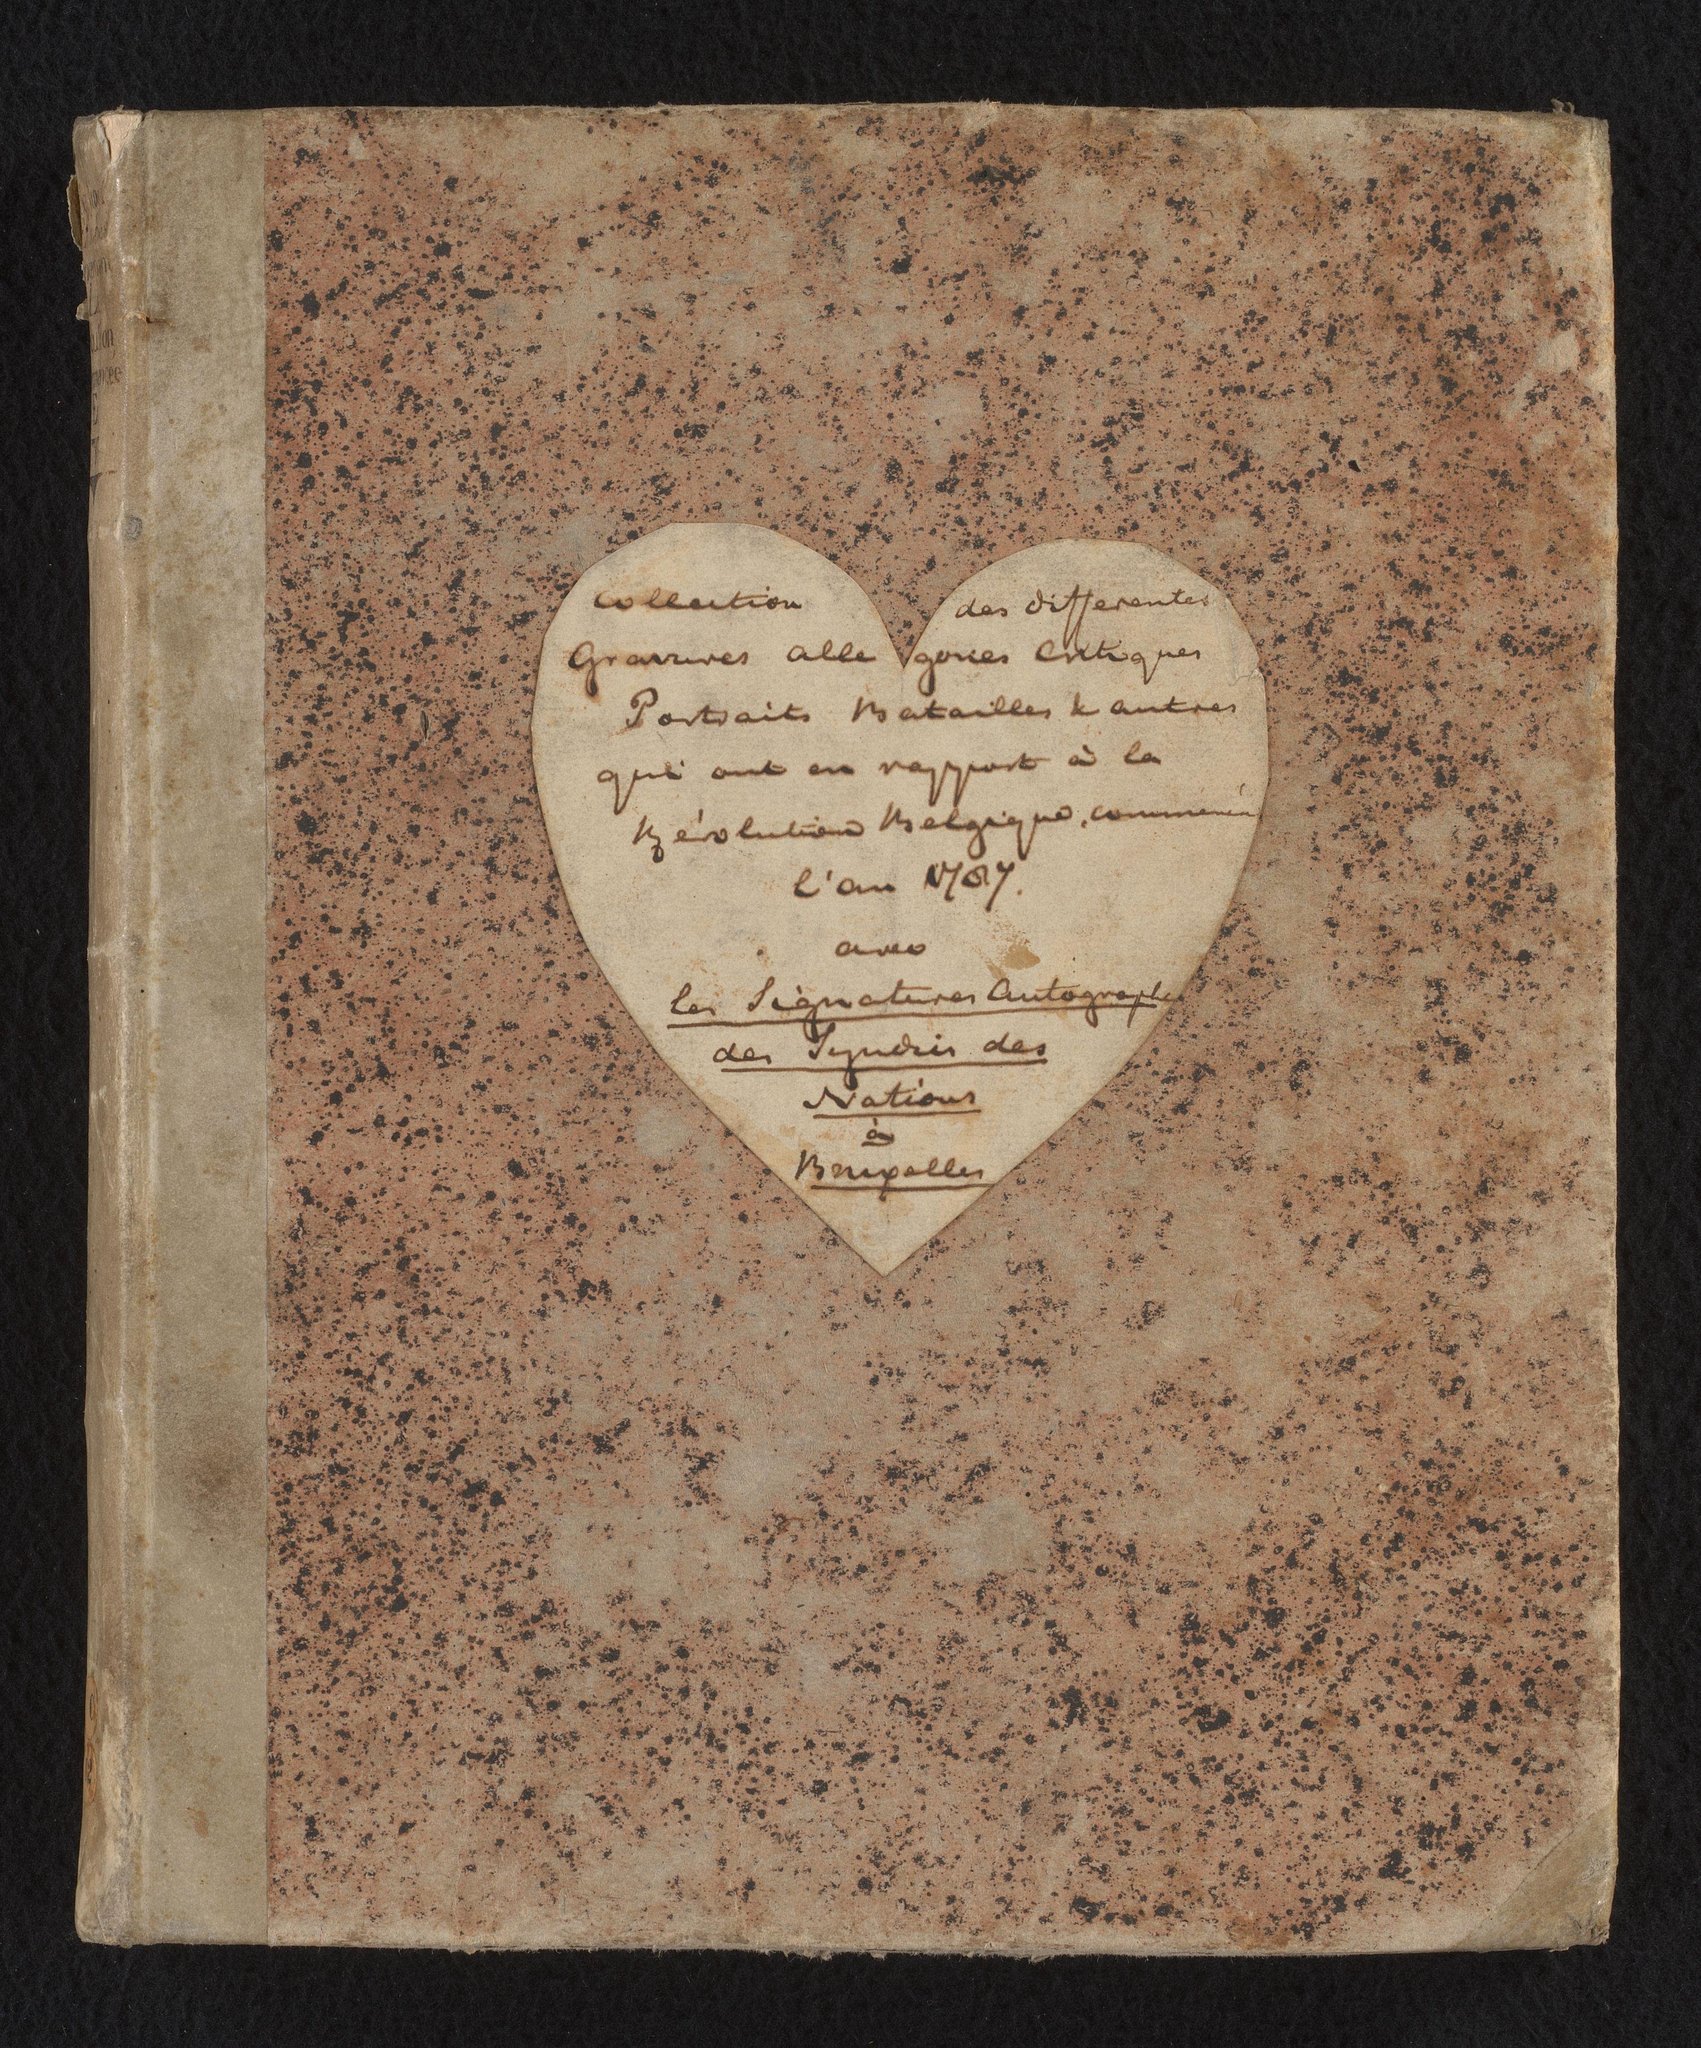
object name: binding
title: Collection des differentes Gravures allegories critiques Portraits Batailles et autres qui ont en rapport à la Révolution Belgique, commencée l'an 1787. avec les signatures Autographes des Syndcis des Nations à Bruxelles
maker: jaquet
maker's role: publisher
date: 1787-1790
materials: cardboard, leather, paper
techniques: bookbinding, writing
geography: lille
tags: brabant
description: Voorzijde omslag en rug van de gebundelde verzameling prenten betrekking hebbend op de gebeurtenissen van de Brabantse Omwenteling en de periode 1787-1790.